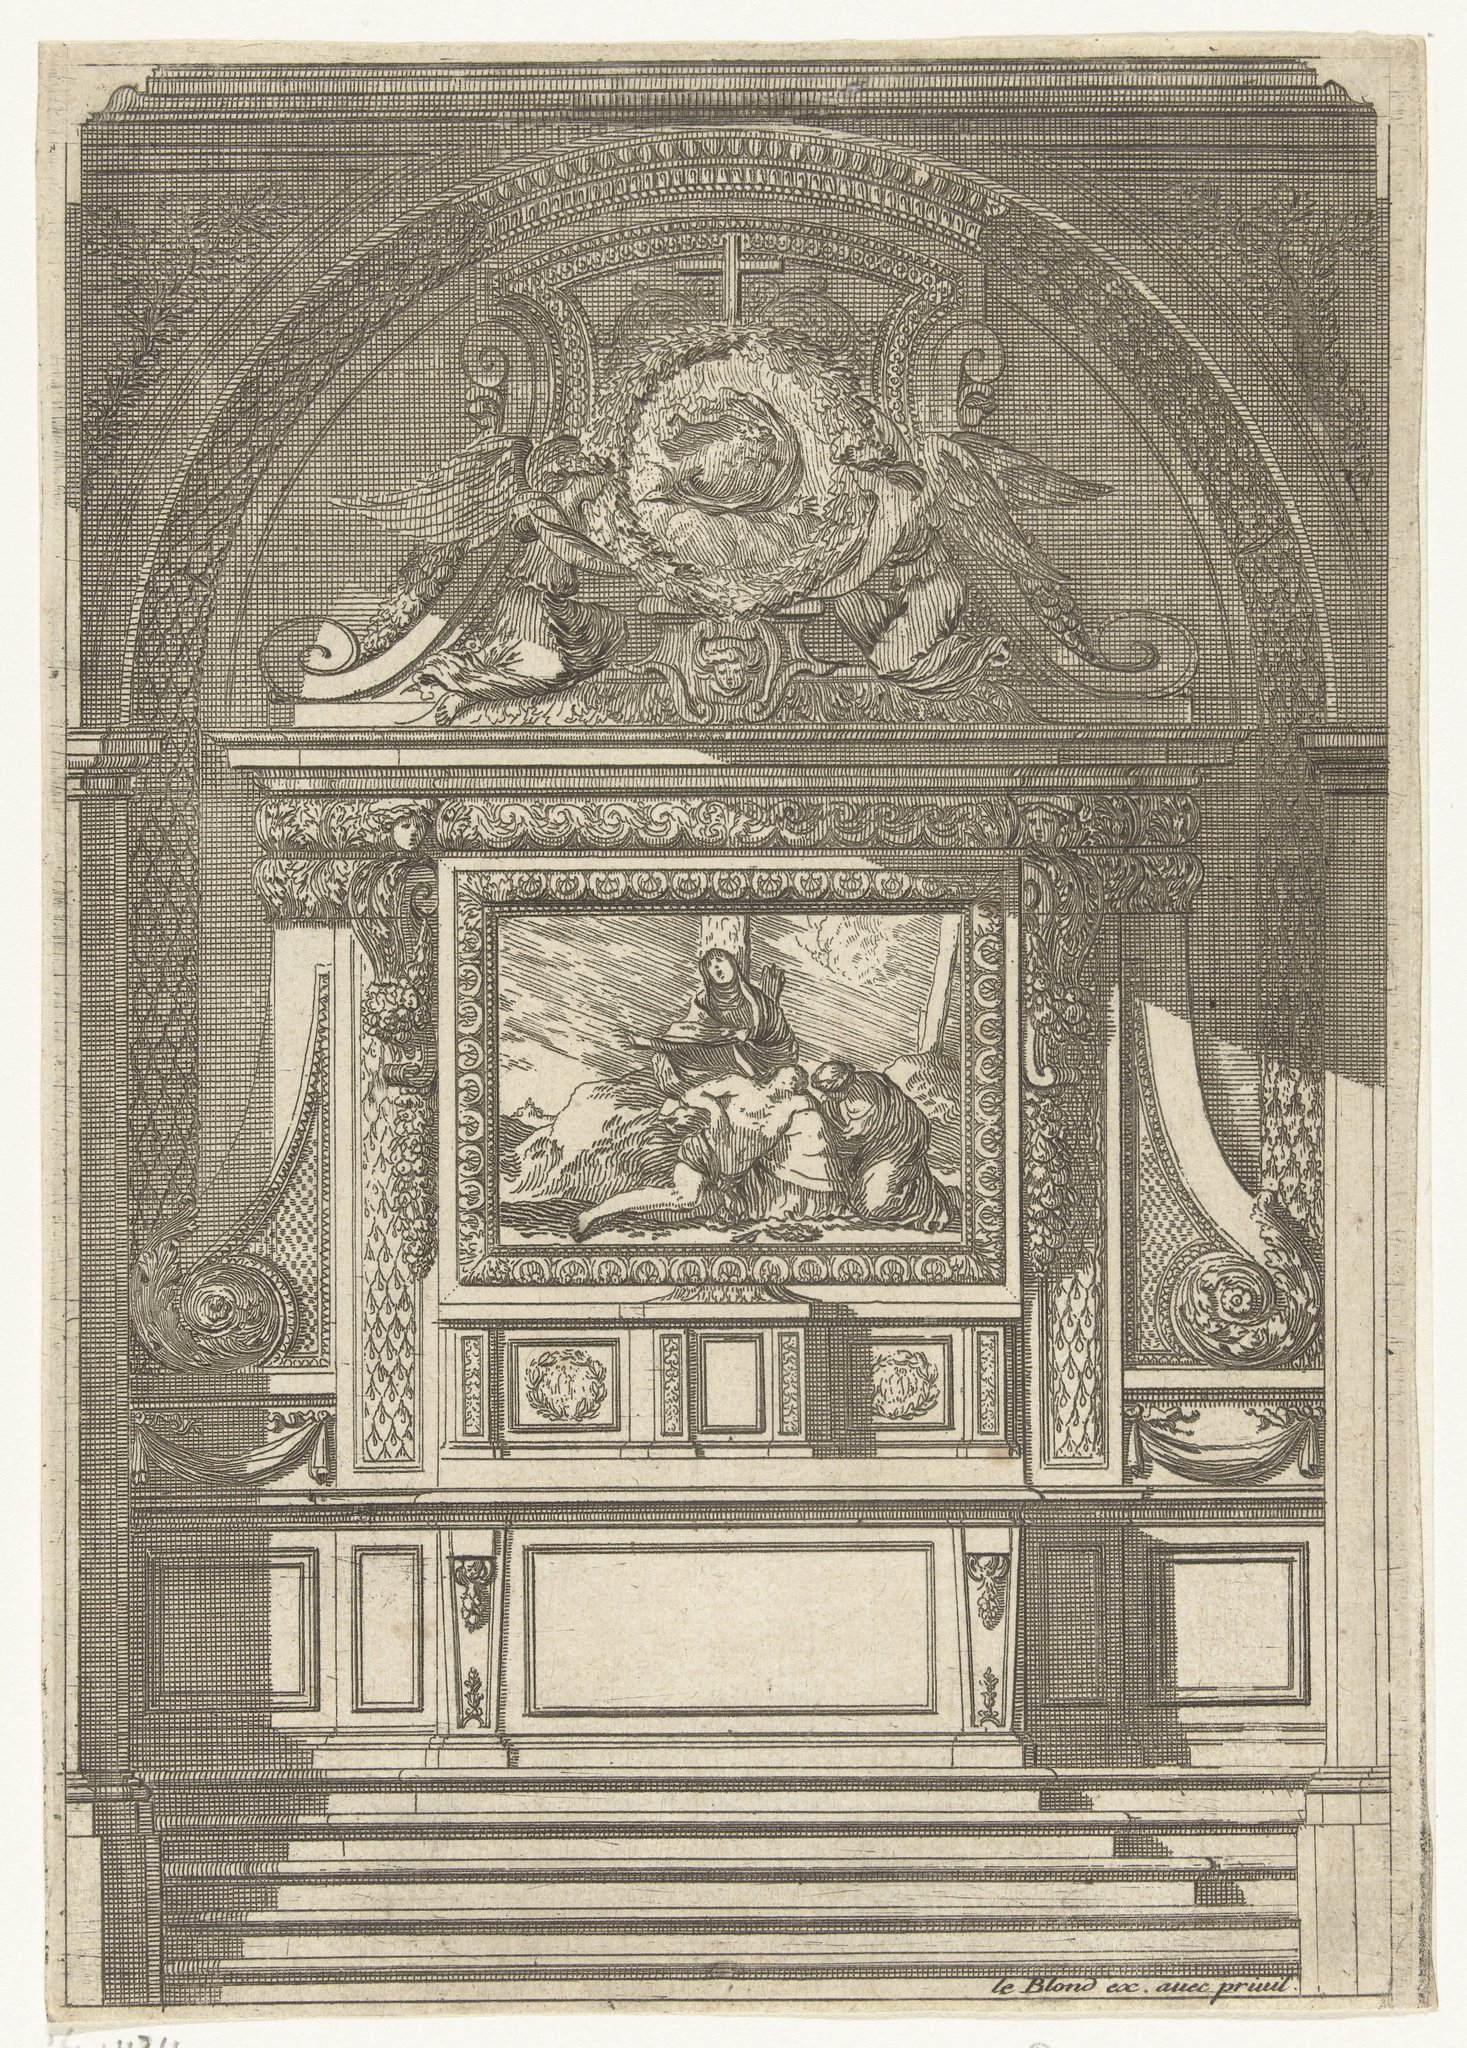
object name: ornament print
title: Authels et Retables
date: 1651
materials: paper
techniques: etching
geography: france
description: In het midden hangt een schilderij met de Bewening van Christus. Blad 7 uit serie van 12 bladen met altaren en tabernakels. Eerste editie.